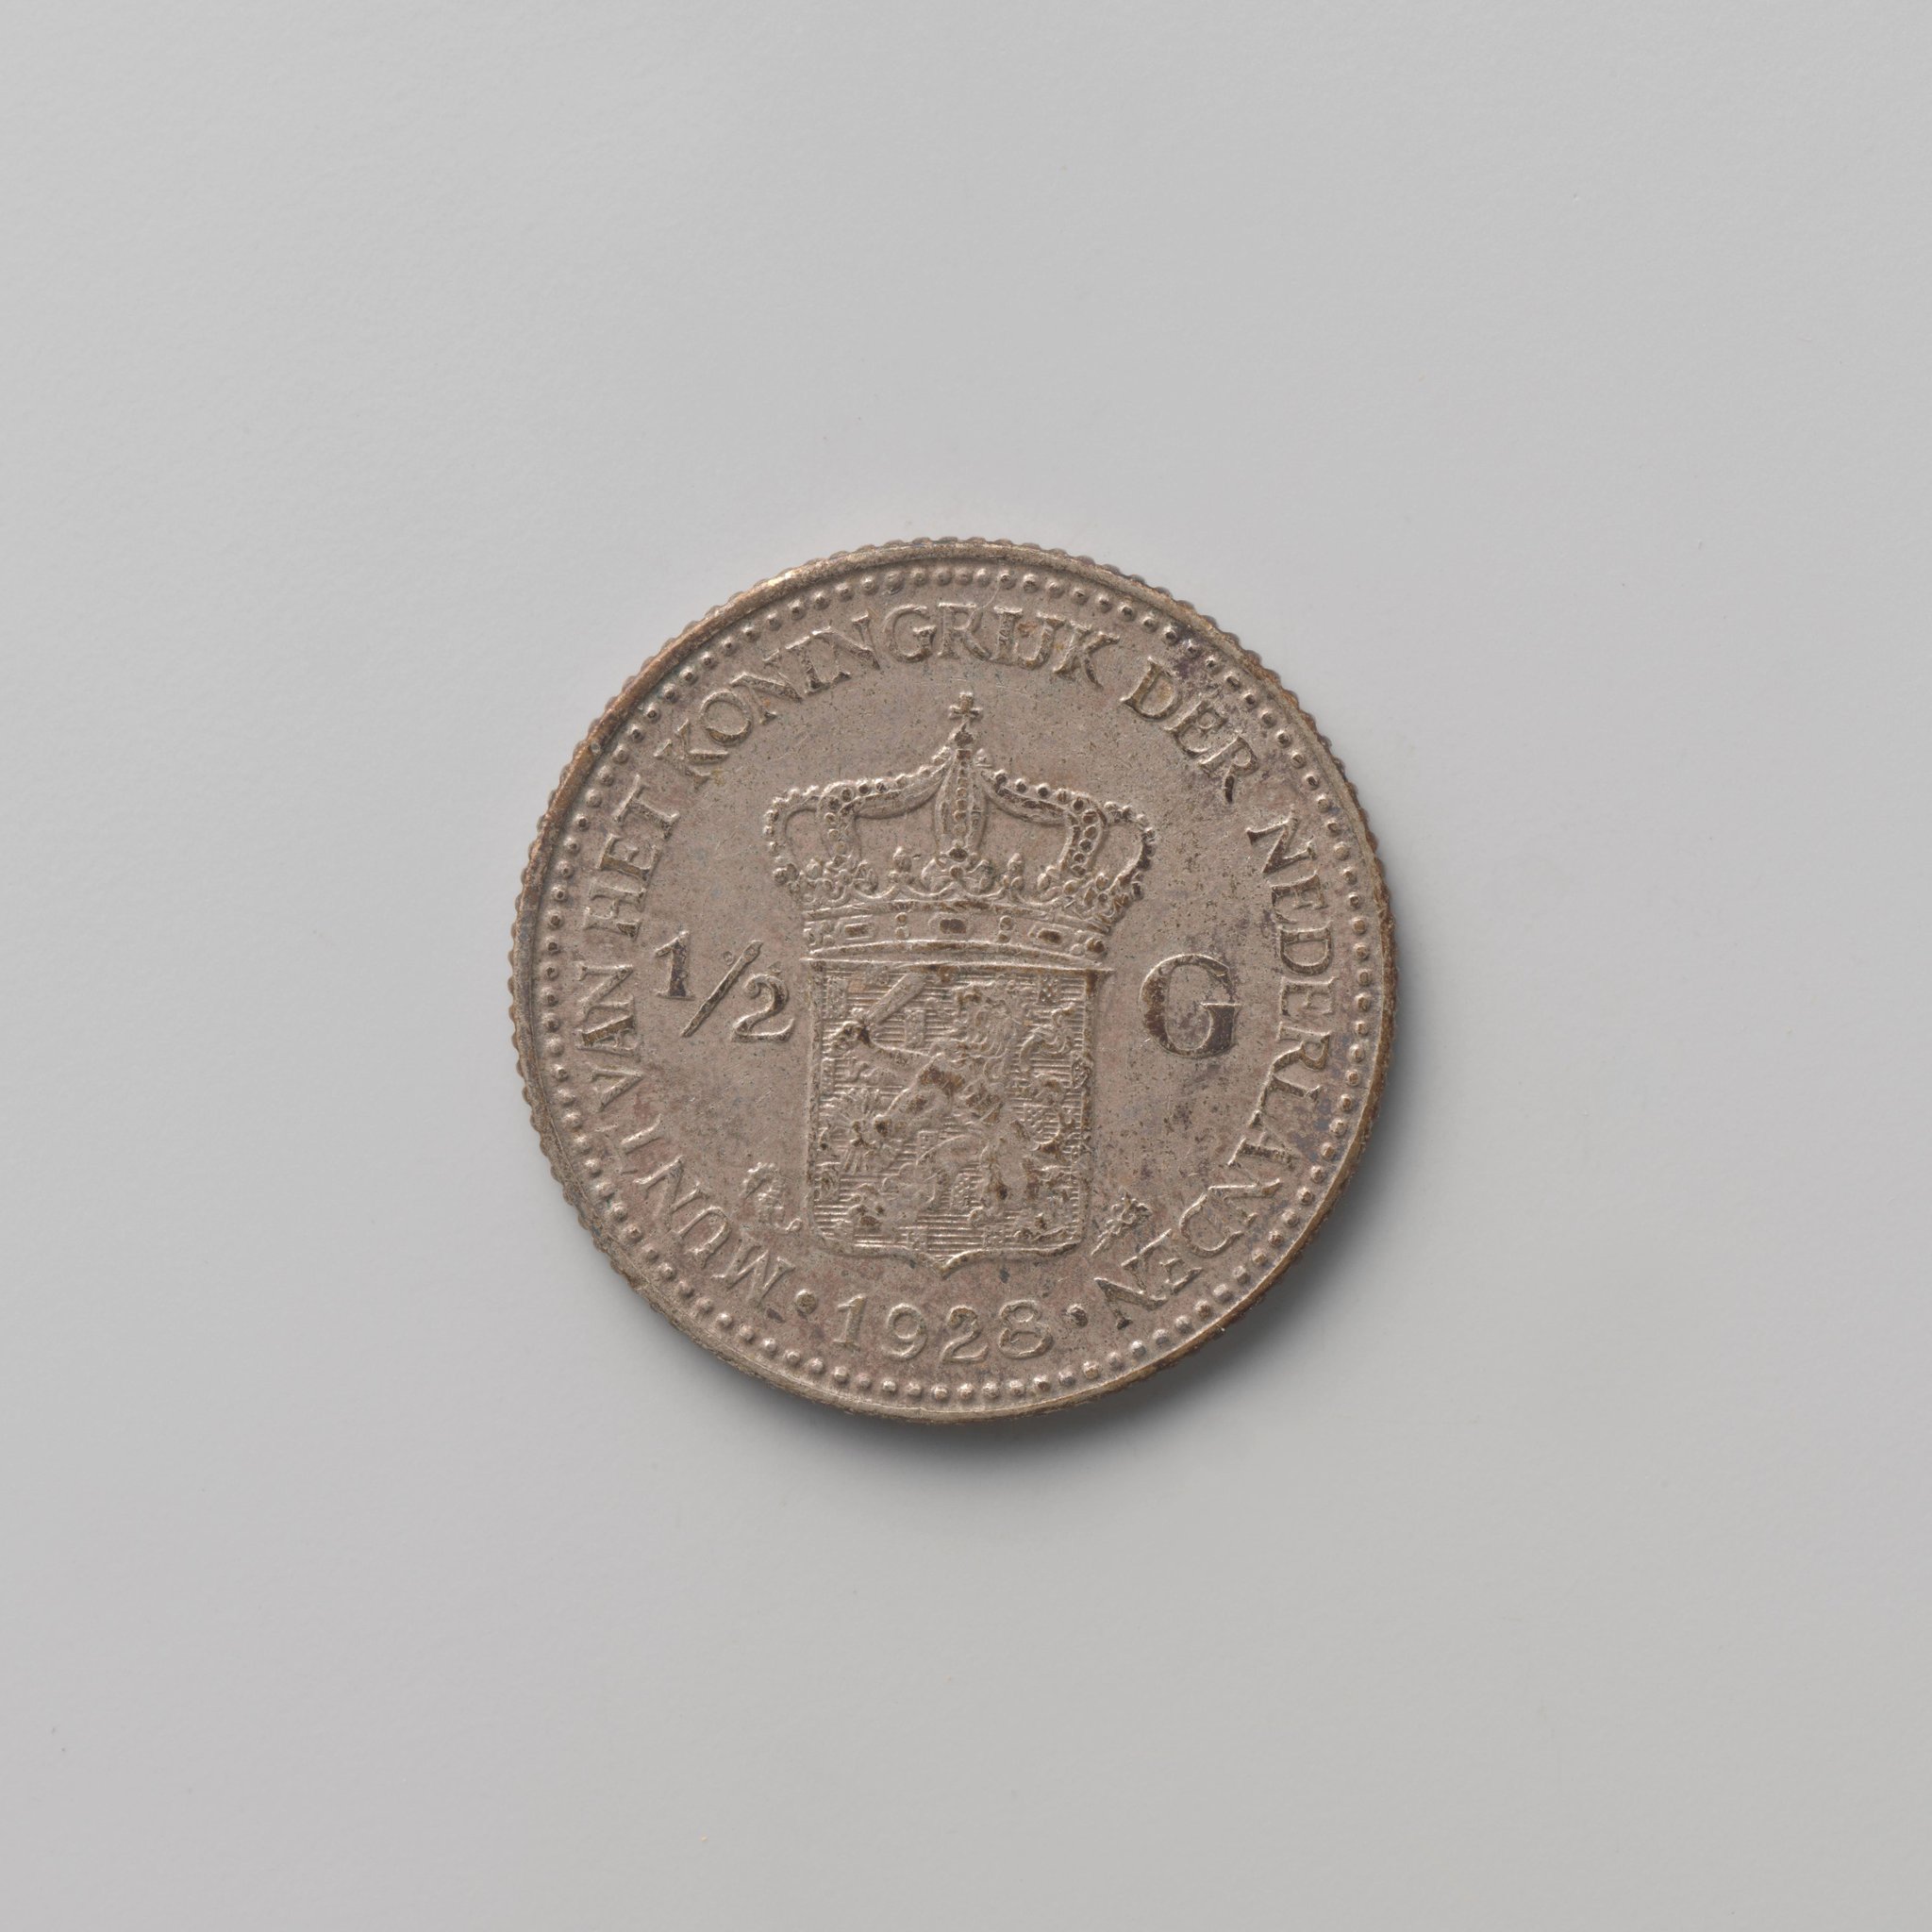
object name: coin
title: Nederlandse ½ gulden,1928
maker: wilhelmina of the netherlands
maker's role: print maker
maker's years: 1880-1962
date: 1928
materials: silver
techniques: striking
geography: utrecht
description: Zilveren munt. Voorzijde: hoofd naar links. Keerzijde: tussen waarde-aanduiding ½ G gekroond rijkswapenschild. Jaartal onderaan in omschrift. Kartelrand.